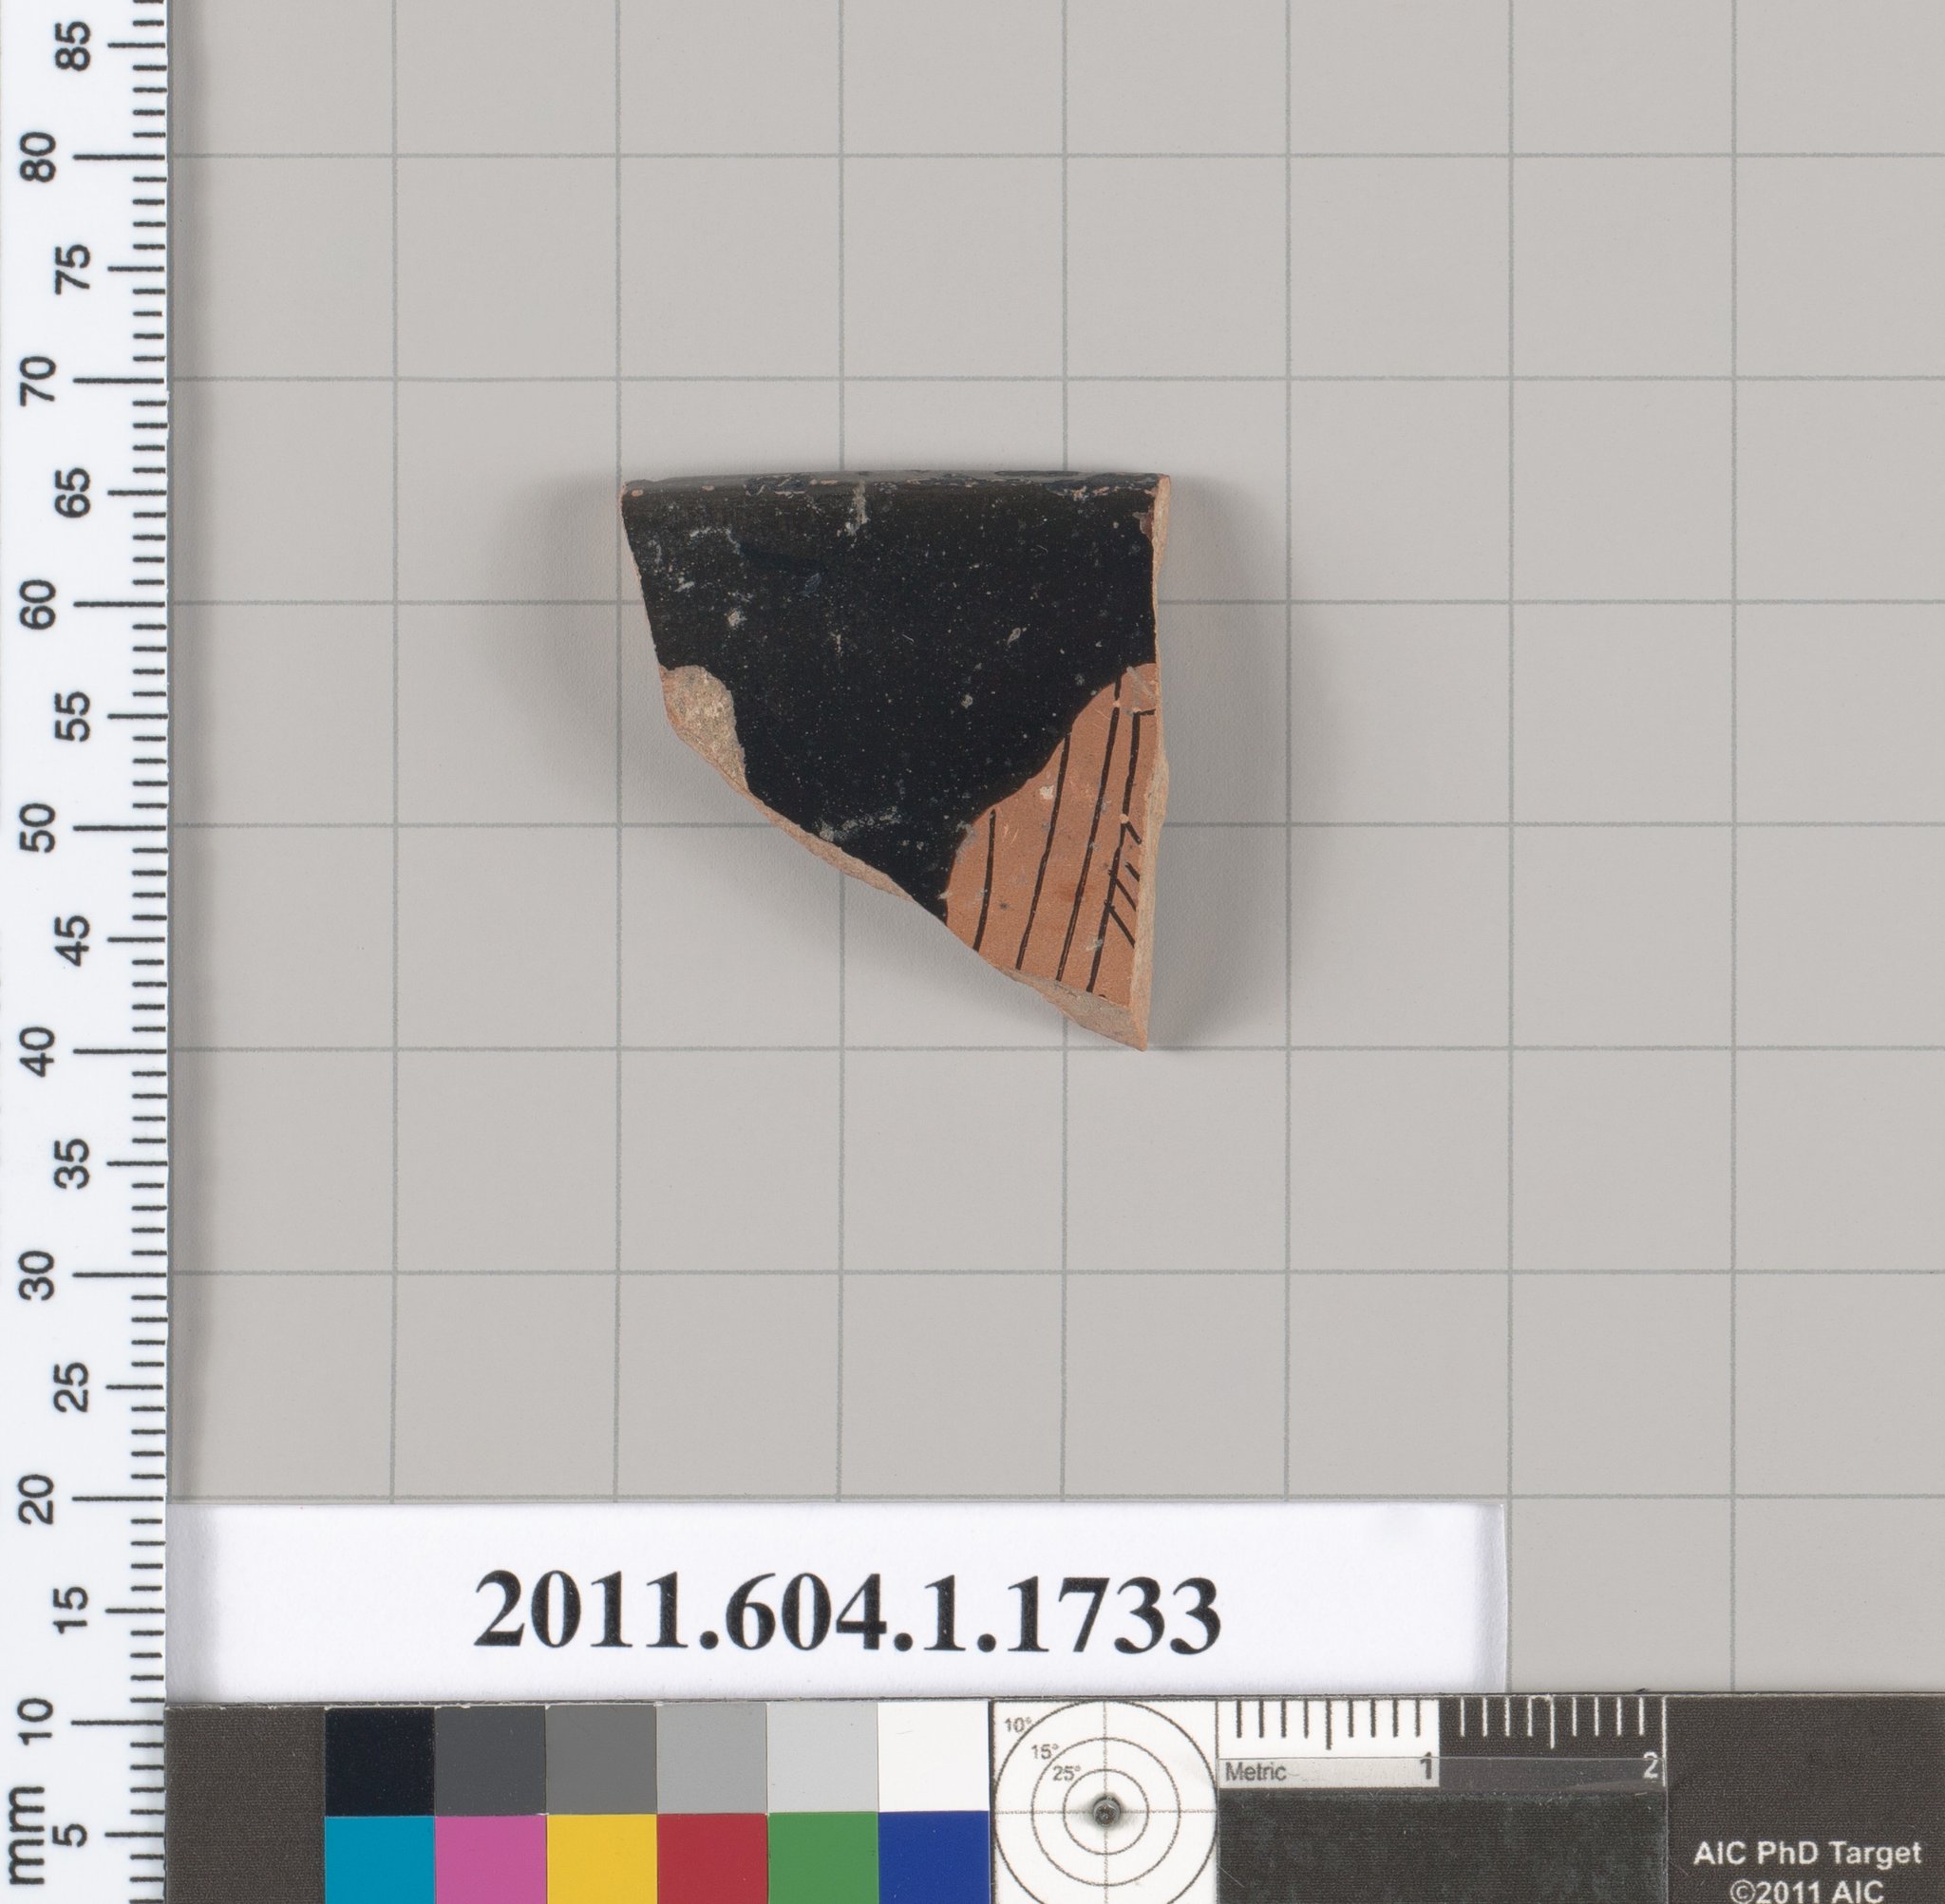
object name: kylix fragment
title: Terracotta rim fragment of a kylix (drinking cup)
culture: greek, attic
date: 475-451 BCE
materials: terracotta